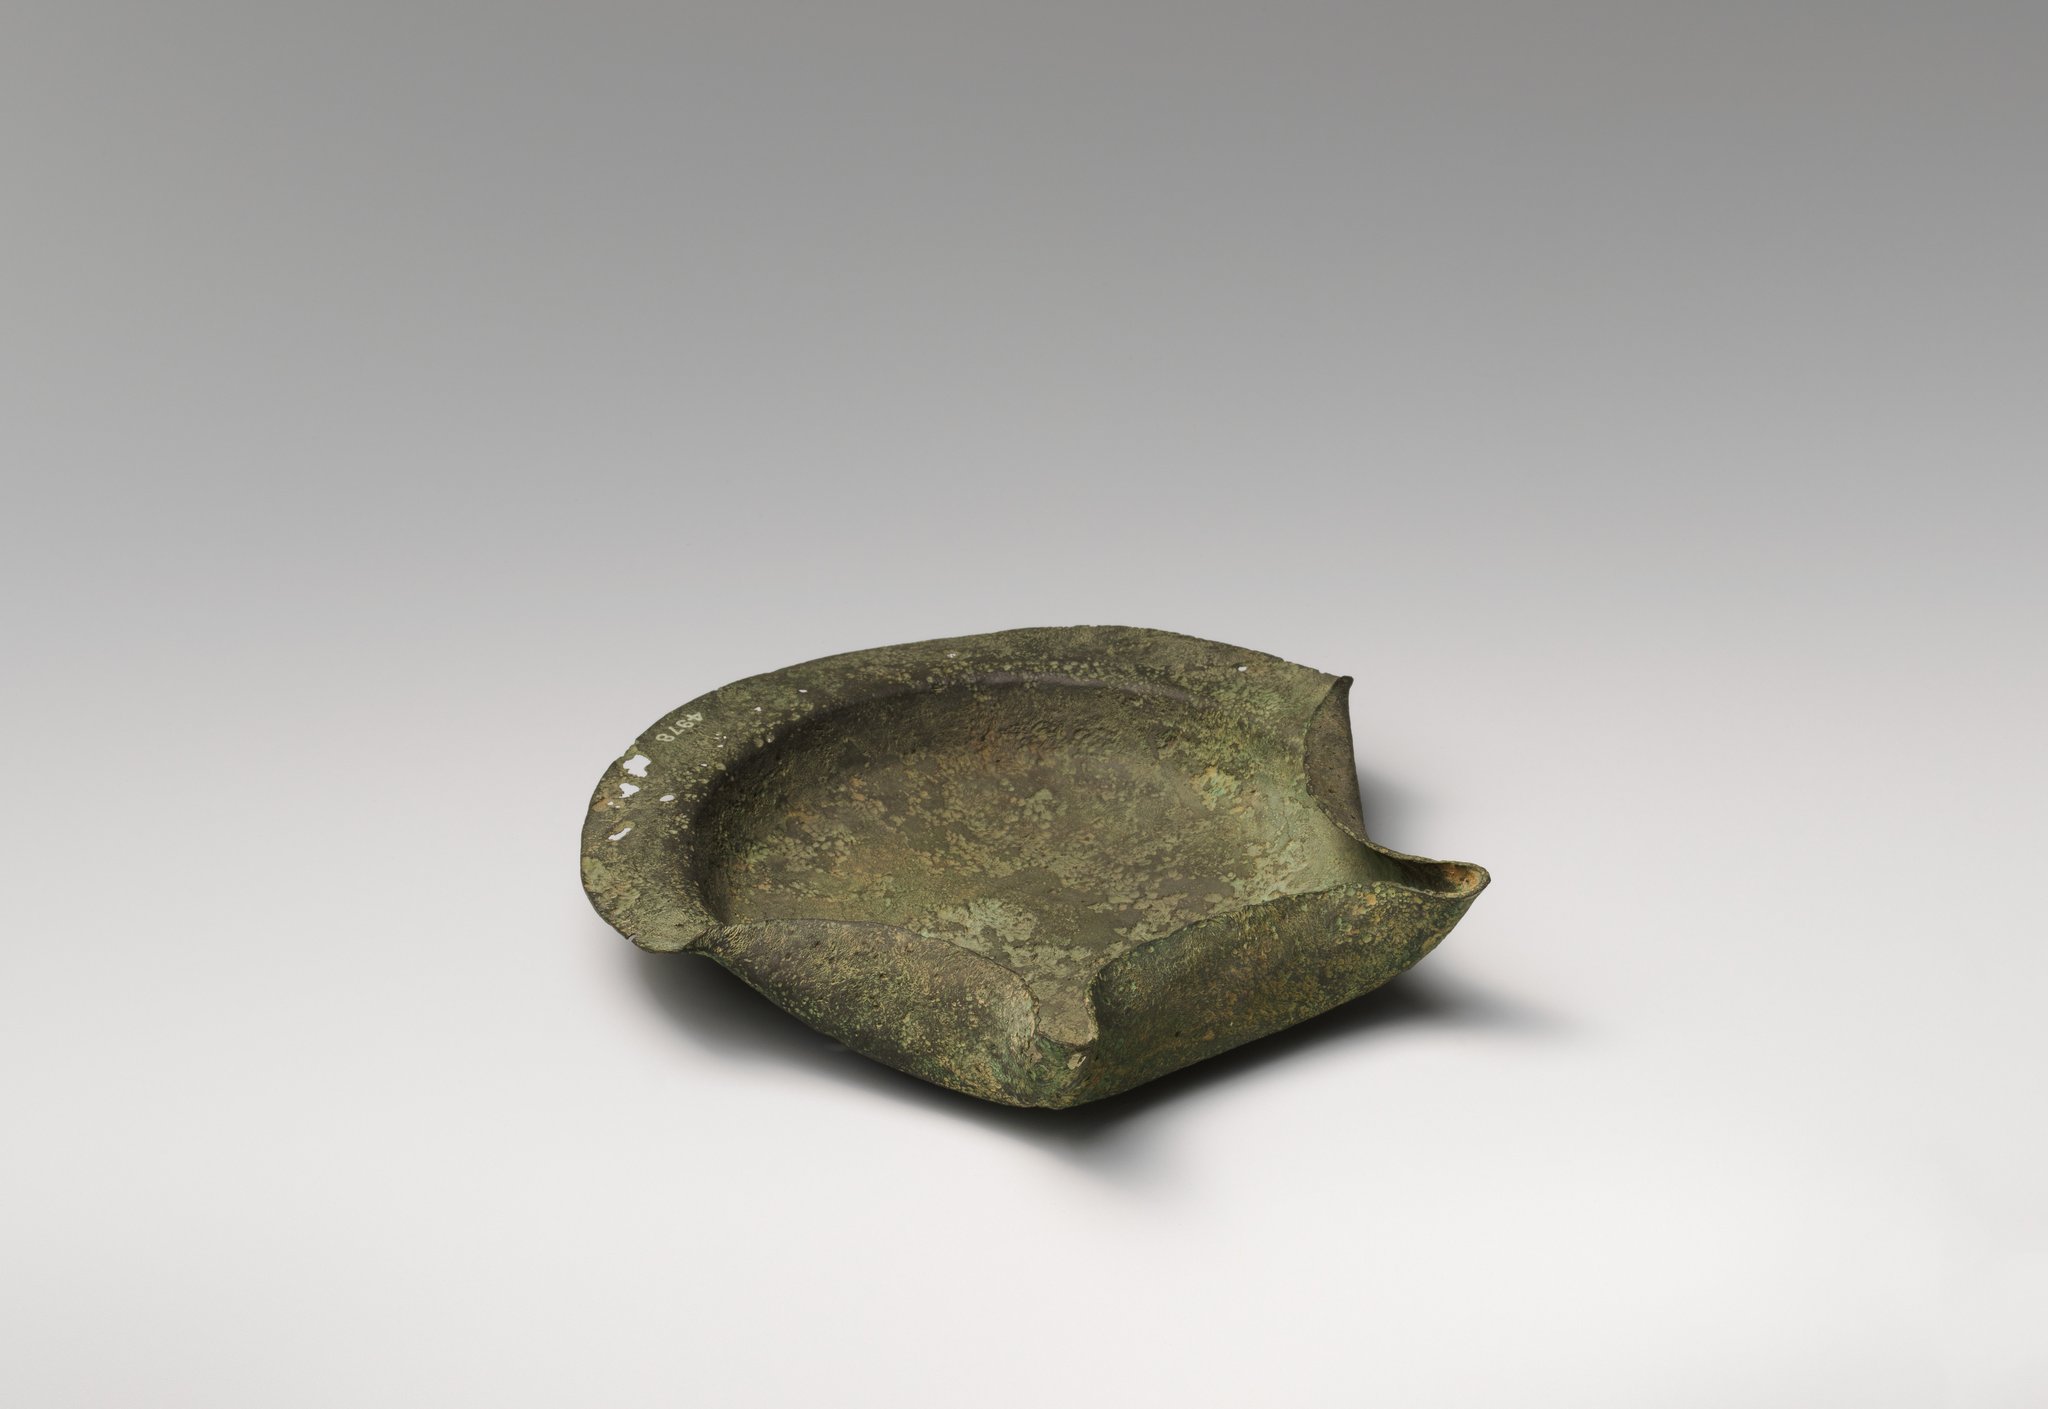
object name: lamp, saucer shaped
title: Bronze saucer-shaped lamp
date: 600-401 BCE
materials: bronze